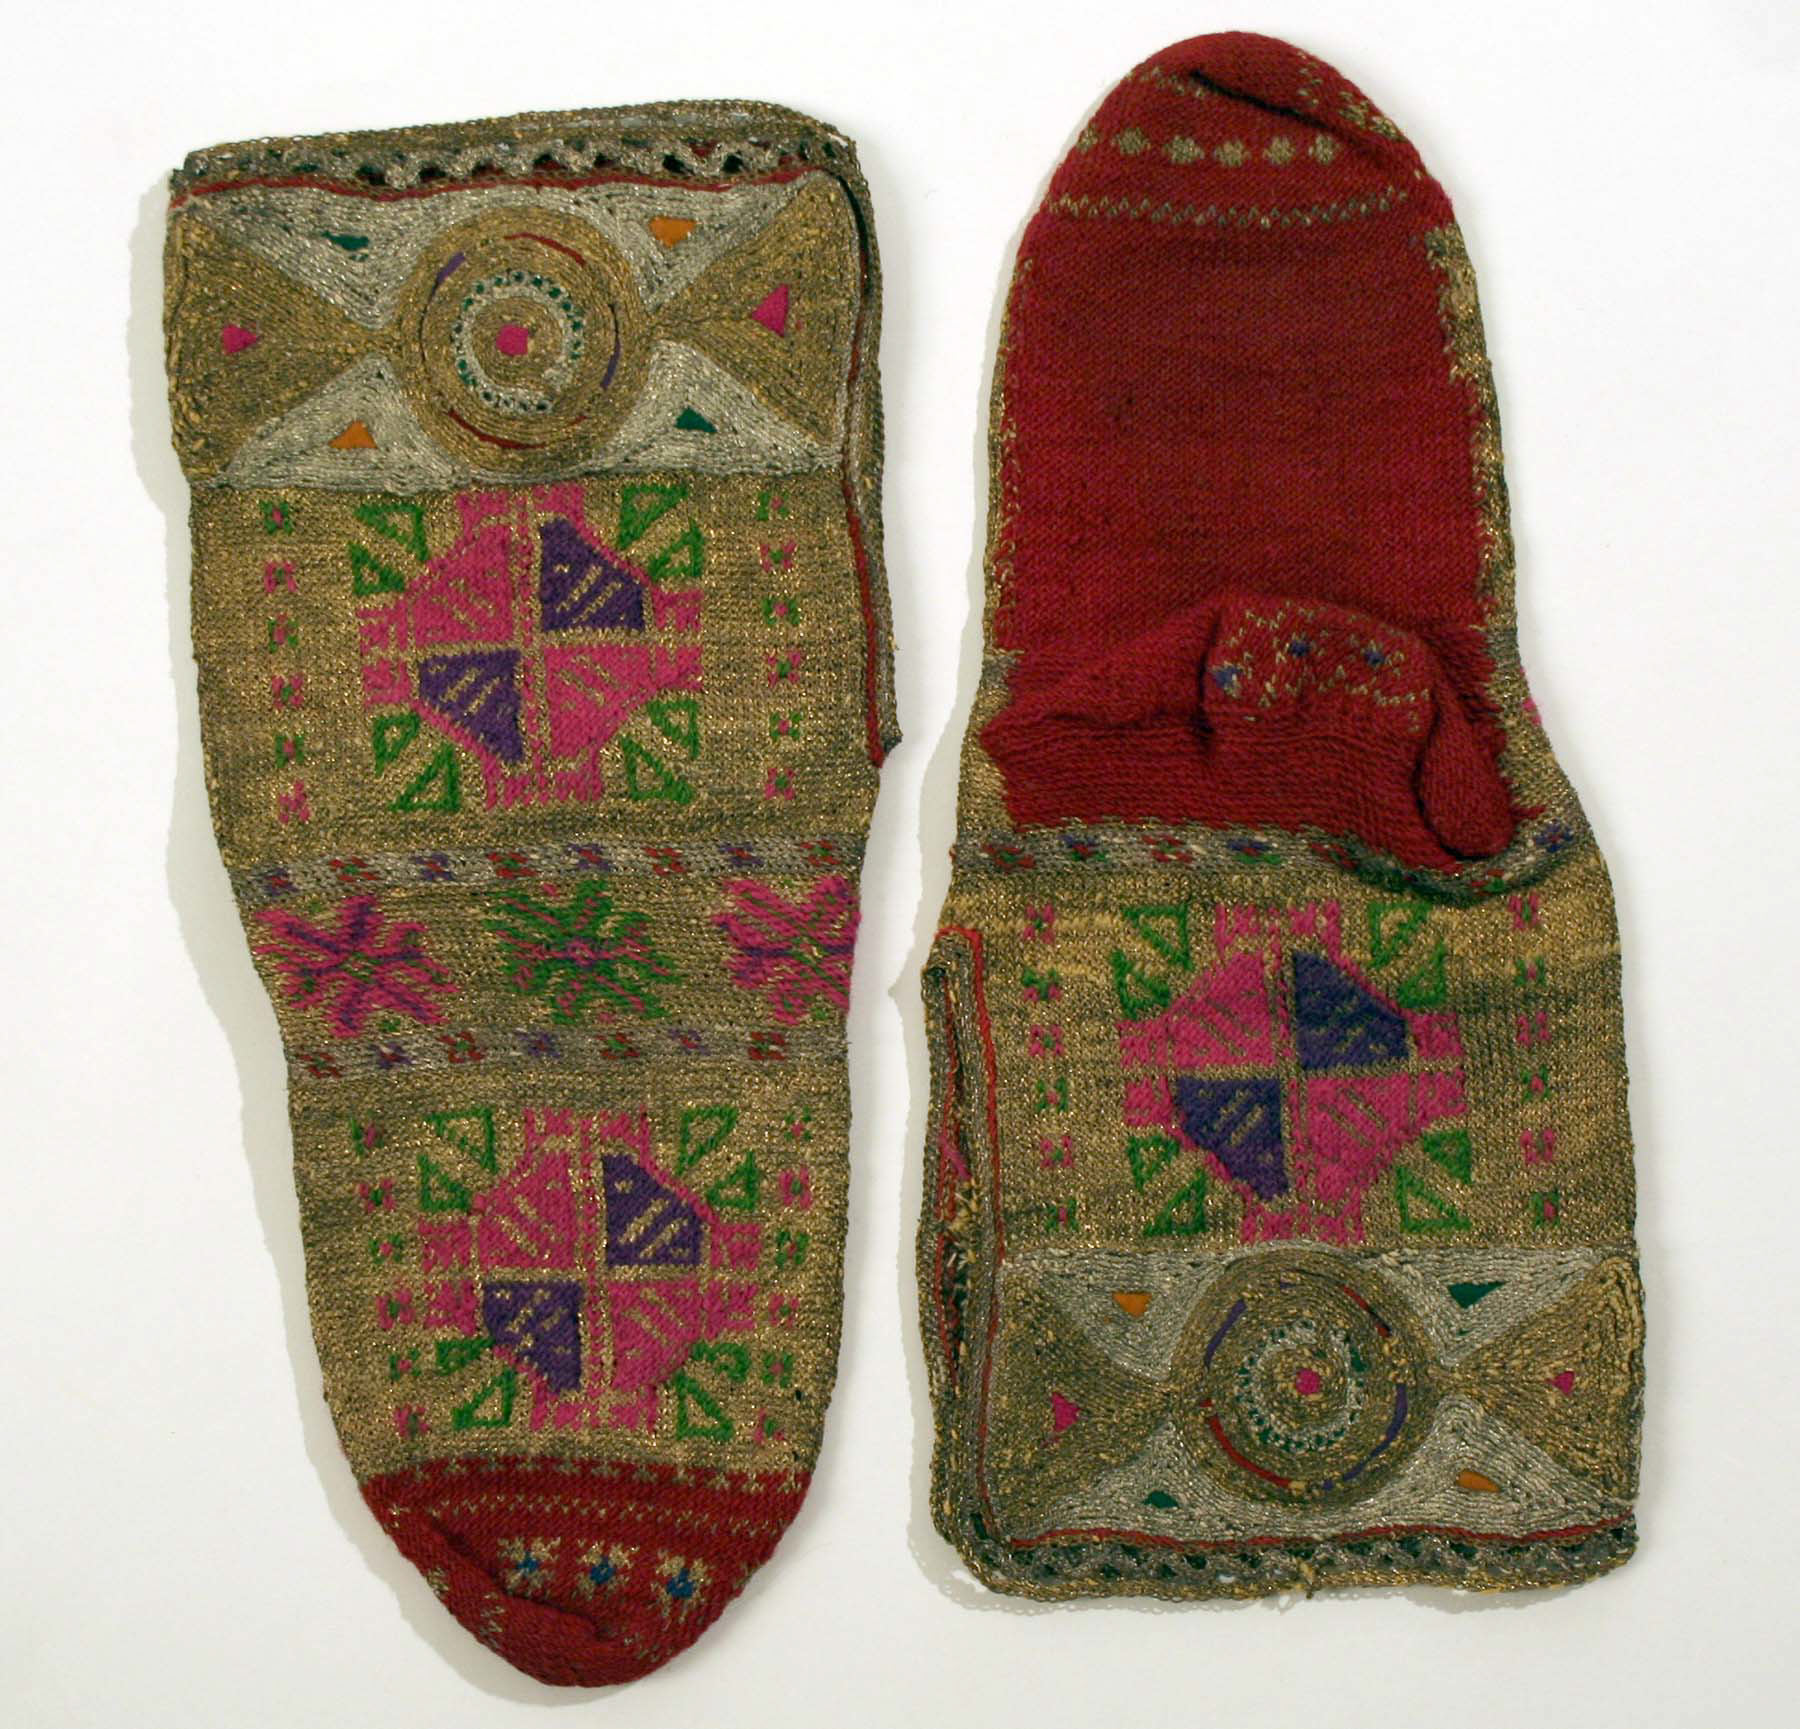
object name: sock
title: Socks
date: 1801-1900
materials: metal thread, wool